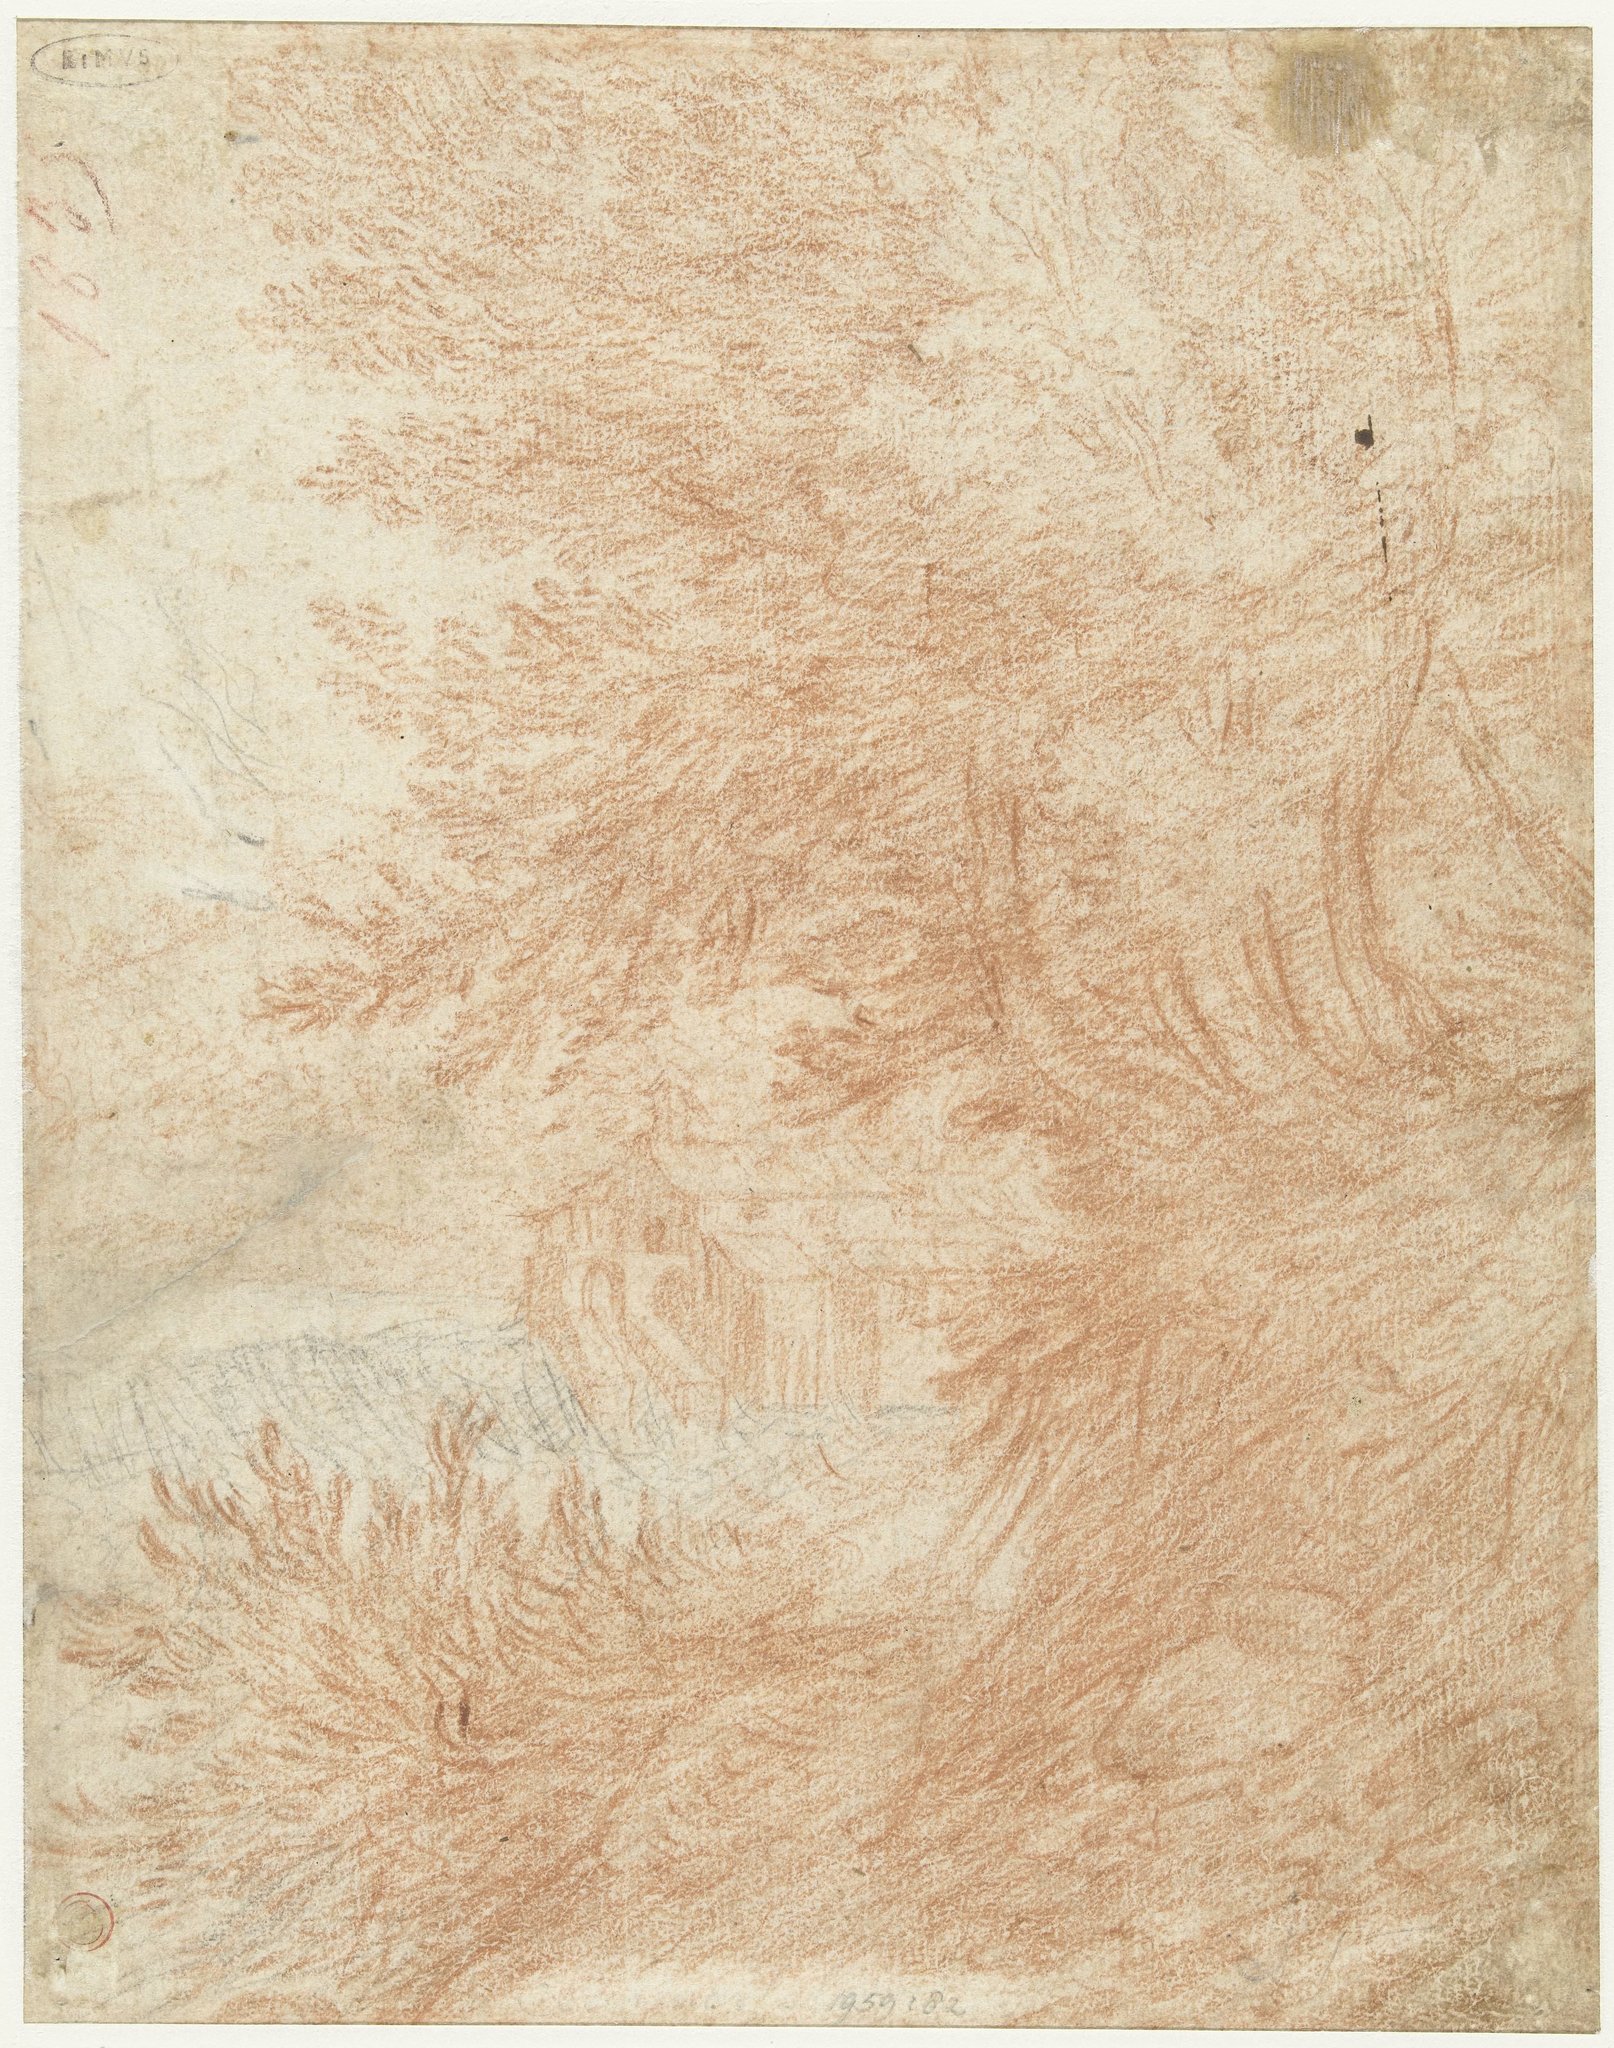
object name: drawing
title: Boomgroep bij een stroomversnelling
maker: angeluccio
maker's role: draughtsman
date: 1640-1660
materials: chalk, pencil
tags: rapids, groups of trees, farm or solitary house in landscape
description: Een boomgroep bij een stroomversnelling met doorkijk naar een gebouw.